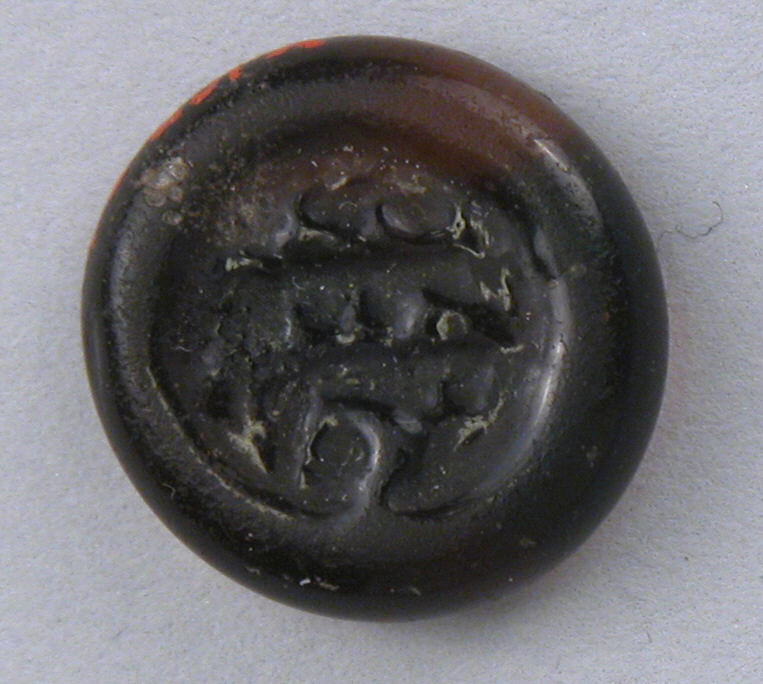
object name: coin weight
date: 1201-1600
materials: glass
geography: egypt